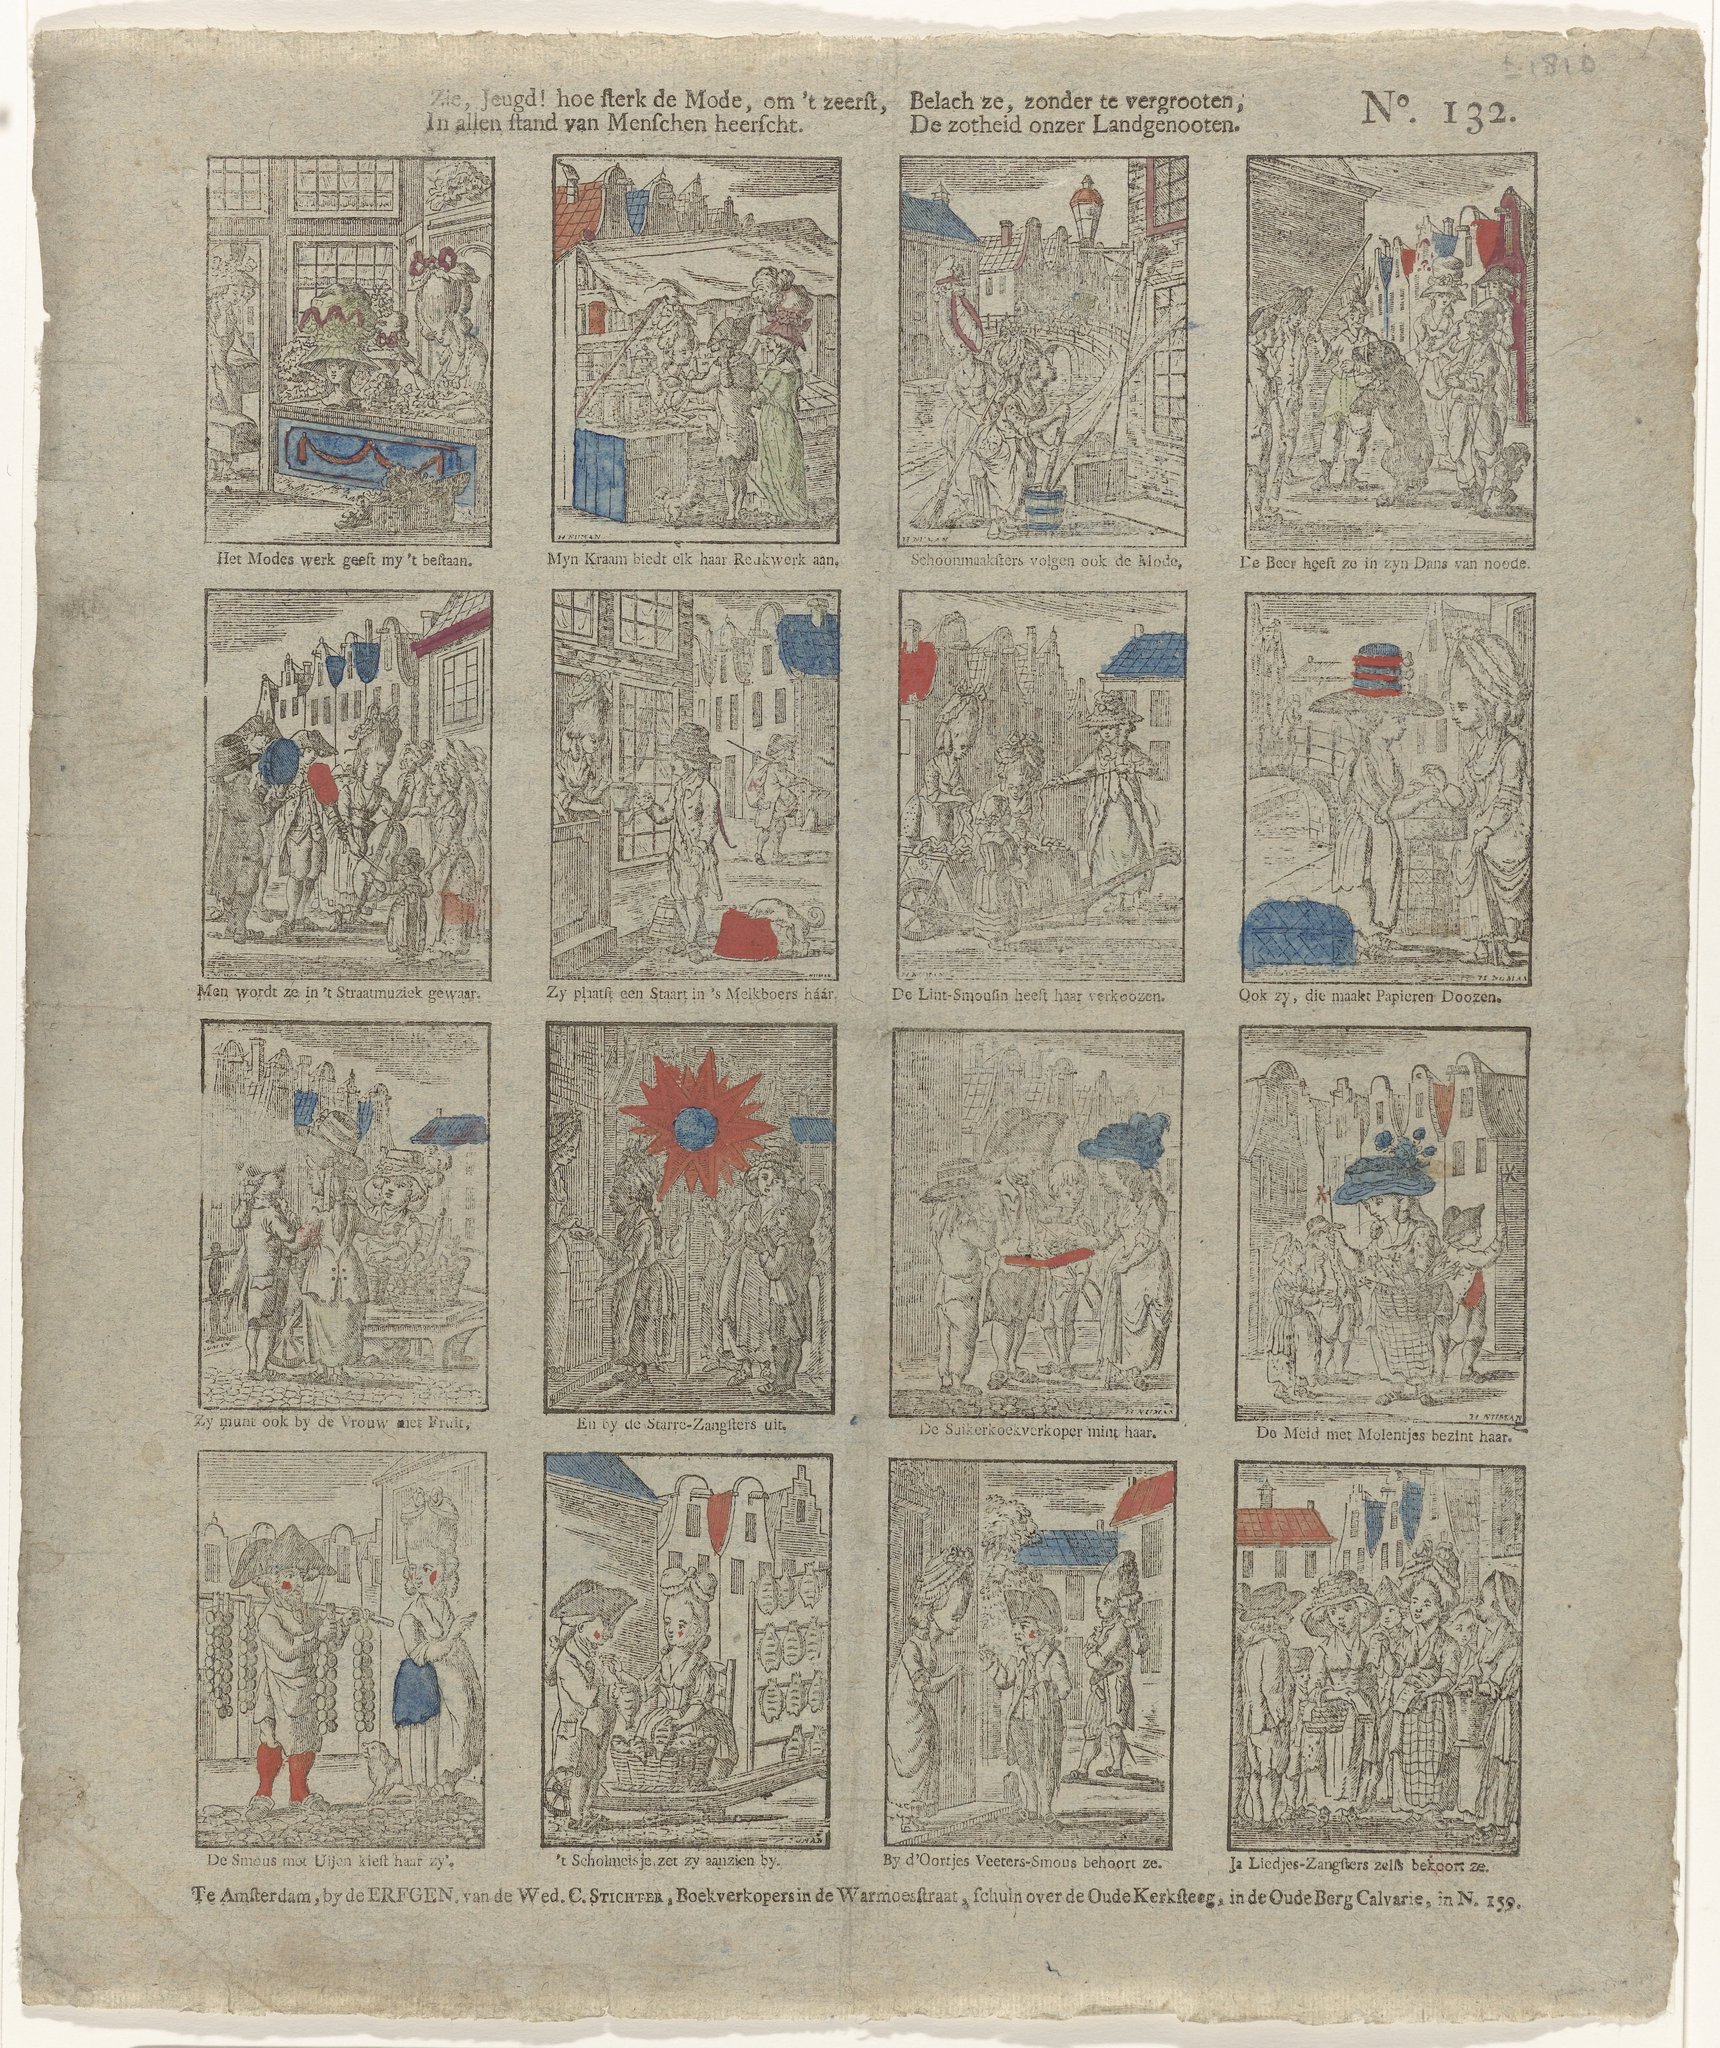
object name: popular print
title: Zie jeugd hoe sterk de mode om ' t zeerst / In allen stand van menschen heerscht. / Belach ze, zonder te vergrooten, - De zotheid onzer landgenooten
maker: weduwe cornelis stichter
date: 1715-1813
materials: paper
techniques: colour, letterpress printing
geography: amsterdam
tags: shop, store, head-gear (+ women's clothes), fashion plates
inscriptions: collector's mark: Lugt 2760, collector's mark: Lugt 2228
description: Spotprent op de mode met 16 voorstellingen van mensen met bijzondere hoeden. Onder elke voorstelling een onderschrift. Genummerd rechtsboven: No. 132.